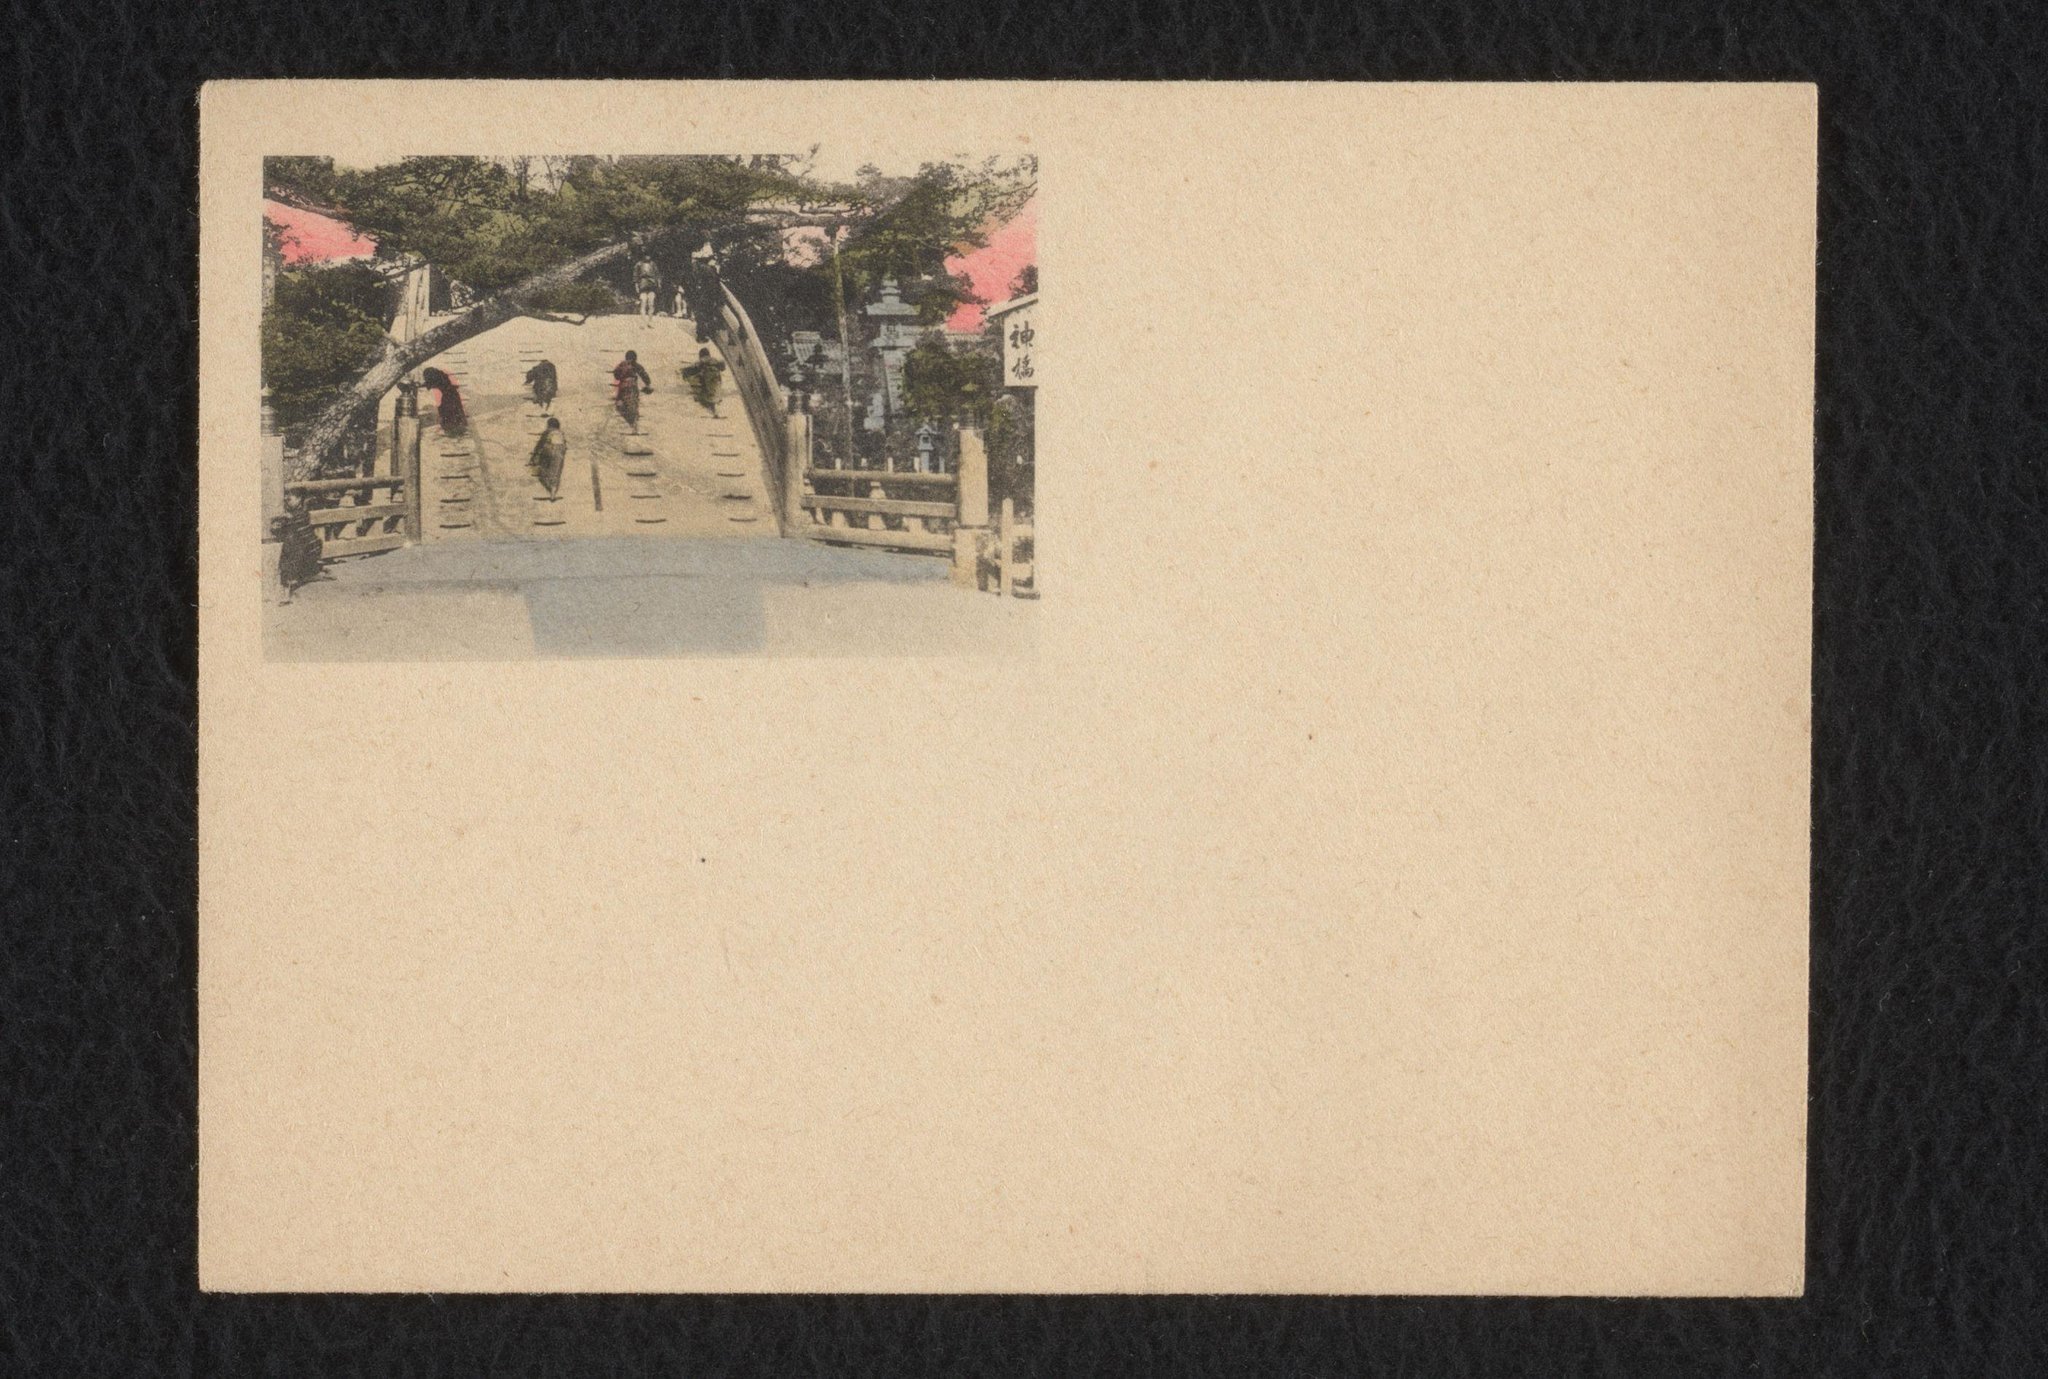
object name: photomechanical print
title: Gezicht op een brug in Sumiyoshi-ku, Osaka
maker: Anonymous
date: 1890-1920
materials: paper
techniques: photograph, lithograph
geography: osaka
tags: bridge